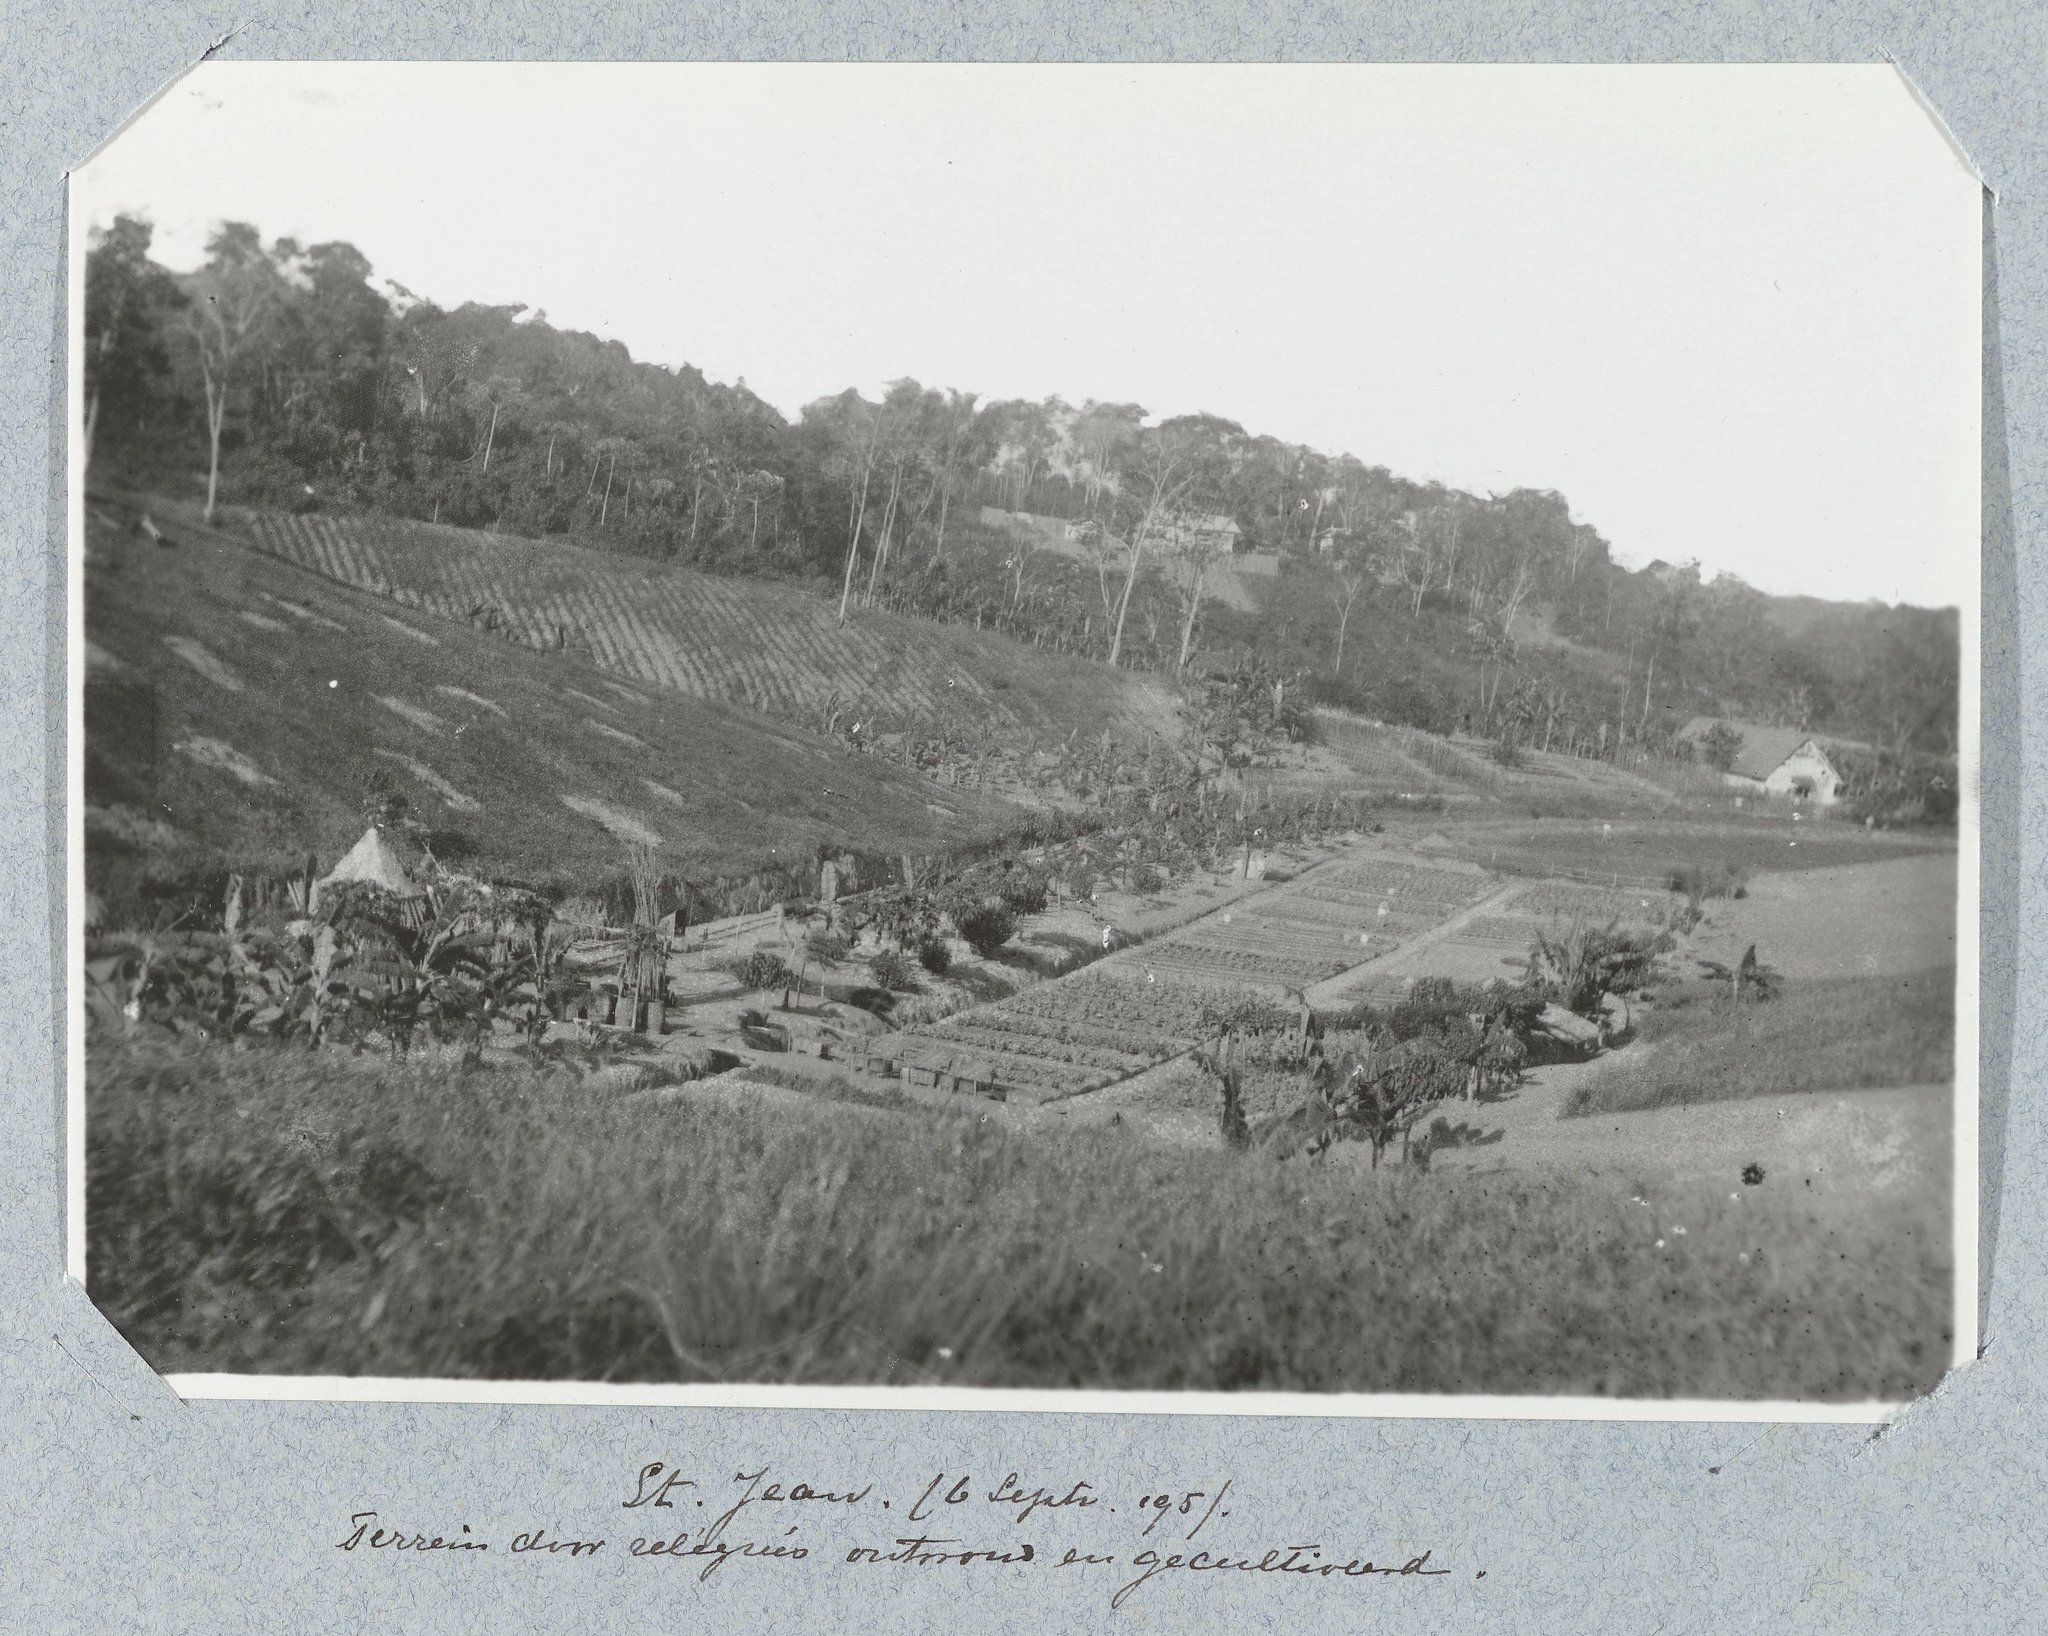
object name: photograph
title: St. Jean. (6 Sept. '95). Terrein door relégués ontwoud en gecultiveerd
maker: théodore van lelyveld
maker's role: painter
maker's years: 1867-1954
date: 1895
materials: photographic support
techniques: gelatin silver print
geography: suriname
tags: workhouse, penal camp, penitentiary, chain gang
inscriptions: inscription: ‘St. Jean. (6 Sept. '95). Terrein door relégués ontwoud en gecultiveerd’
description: Gezicht op een terrein aan de voet van een heuvel bij de strafkolonie St. Jean (Saint-Jean-du-Maroni) te Guyana dat door ballingen (relegués) is ontgonnen en gecultiveerd, 6 september 1895. Fotoafdruk in een fotoalbum van Théodore van Lelyveld over Suriname uit 1895-1898.